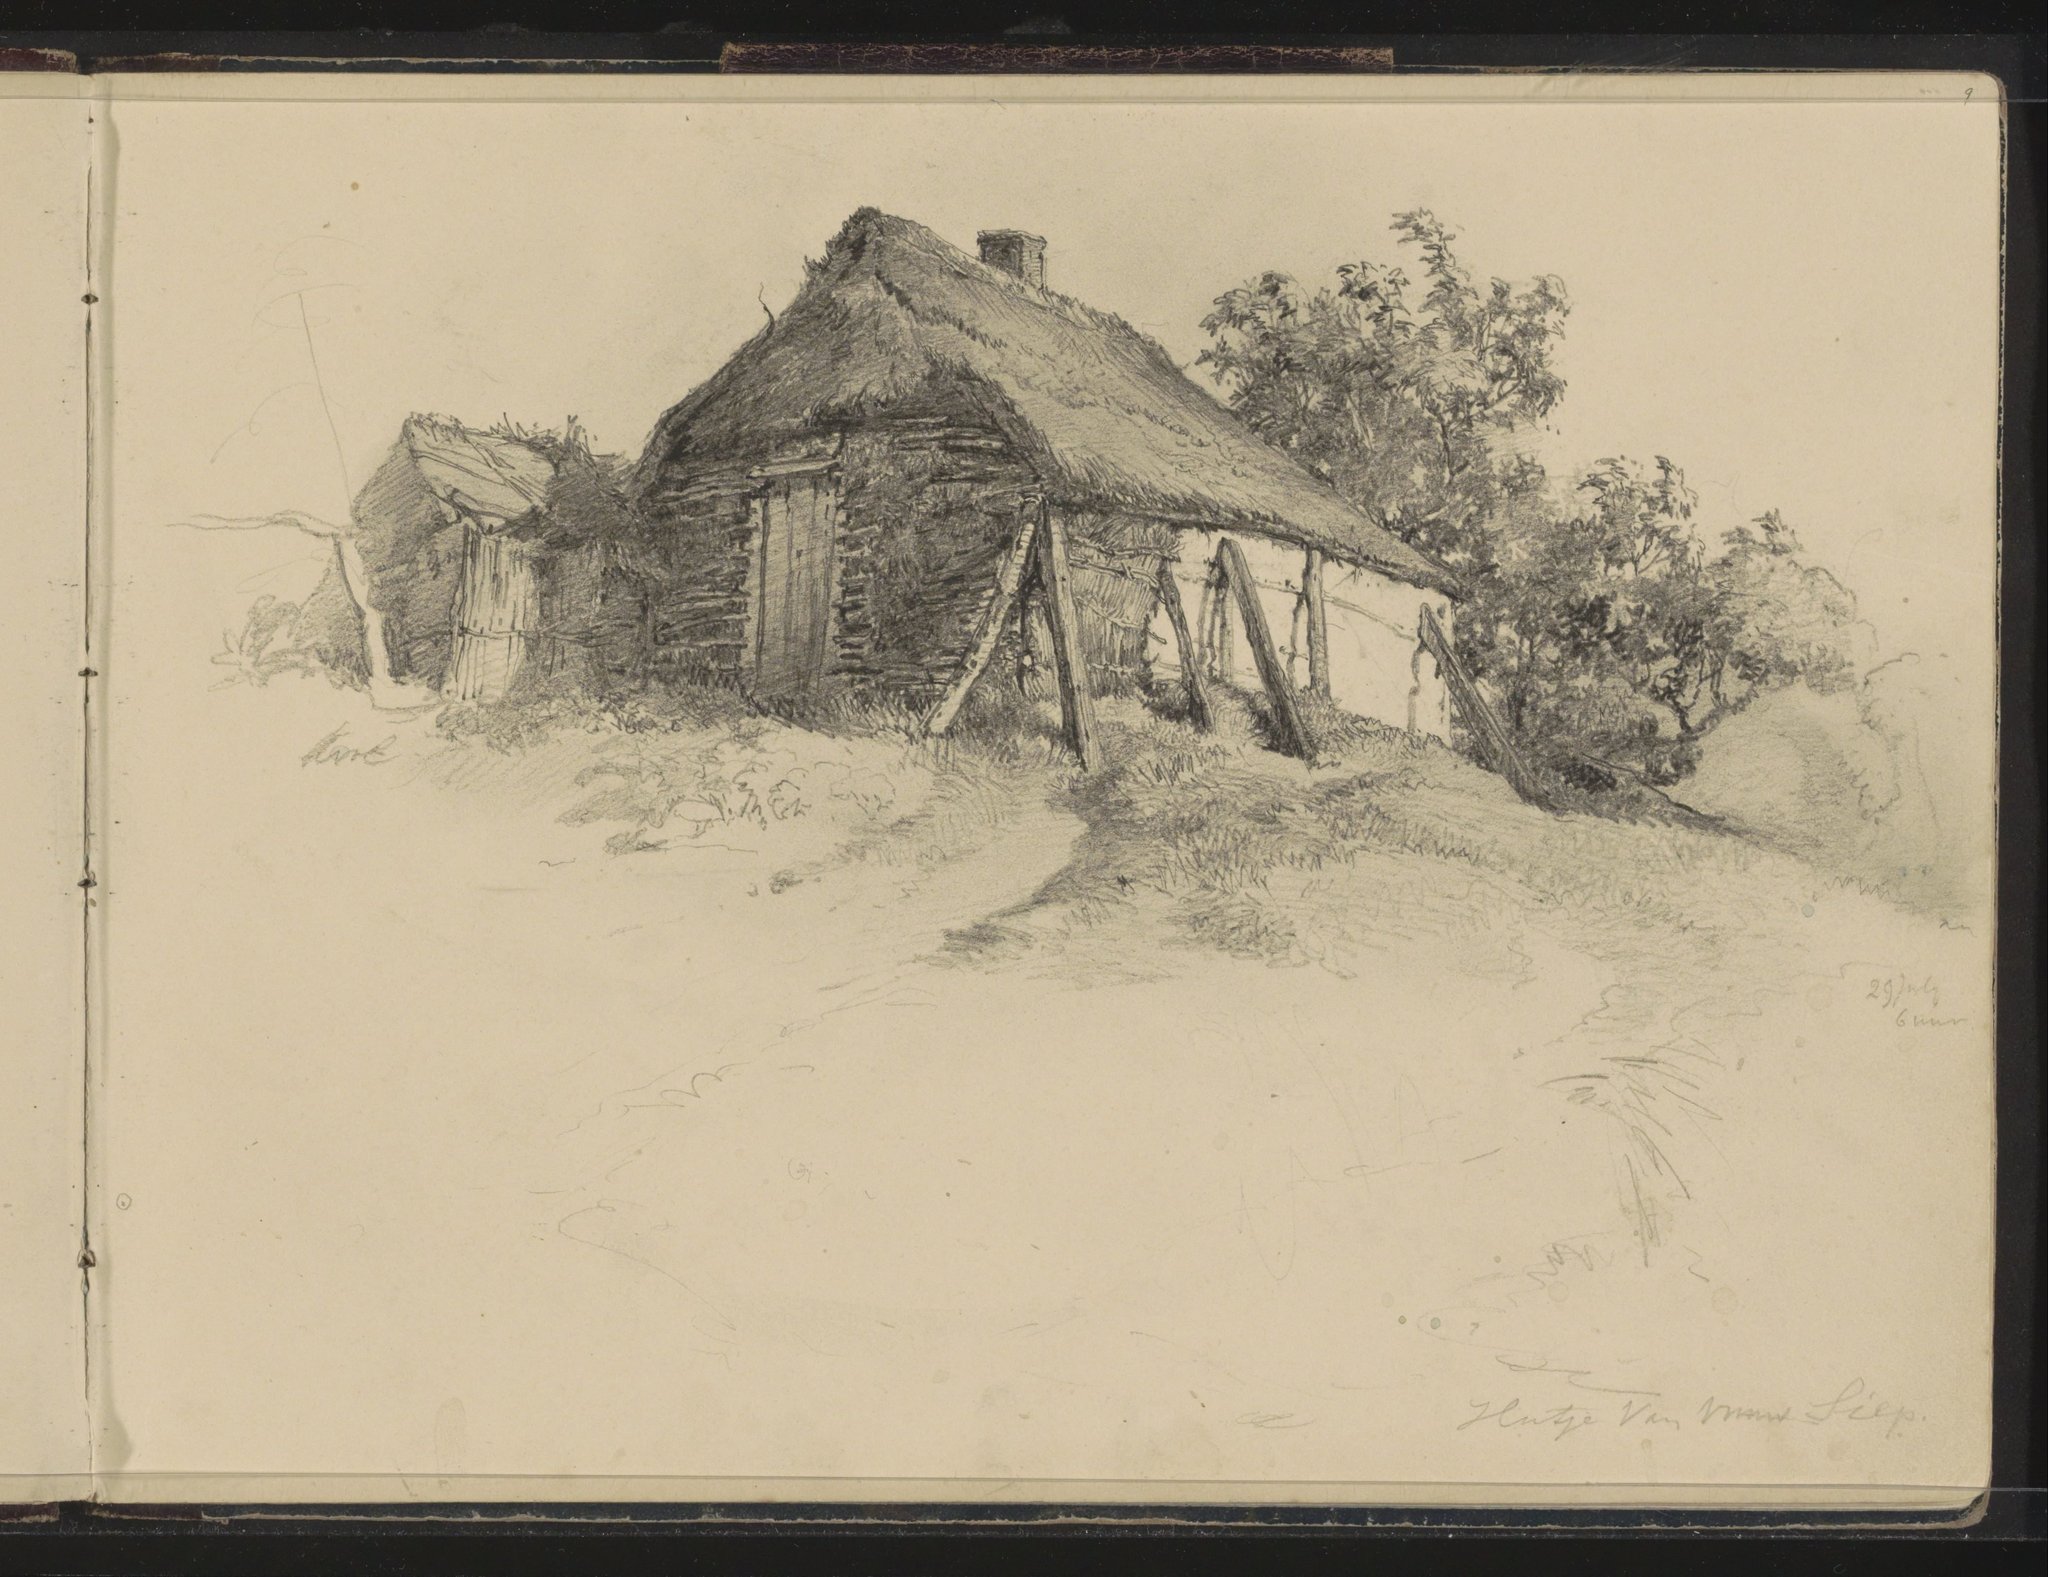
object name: sketchbook leaf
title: Hut met een rieten dak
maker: maria vos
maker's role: draughtsman, painter, print maker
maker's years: 1824-1906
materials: paper, pencil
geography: oosterbeek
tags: hut, cabin, lodge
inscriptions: date and inscription: ‘26 July/ 6 uur/ Hutje van Siep’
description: Blad 9 recto uit een schetsboek met 44 bladen.